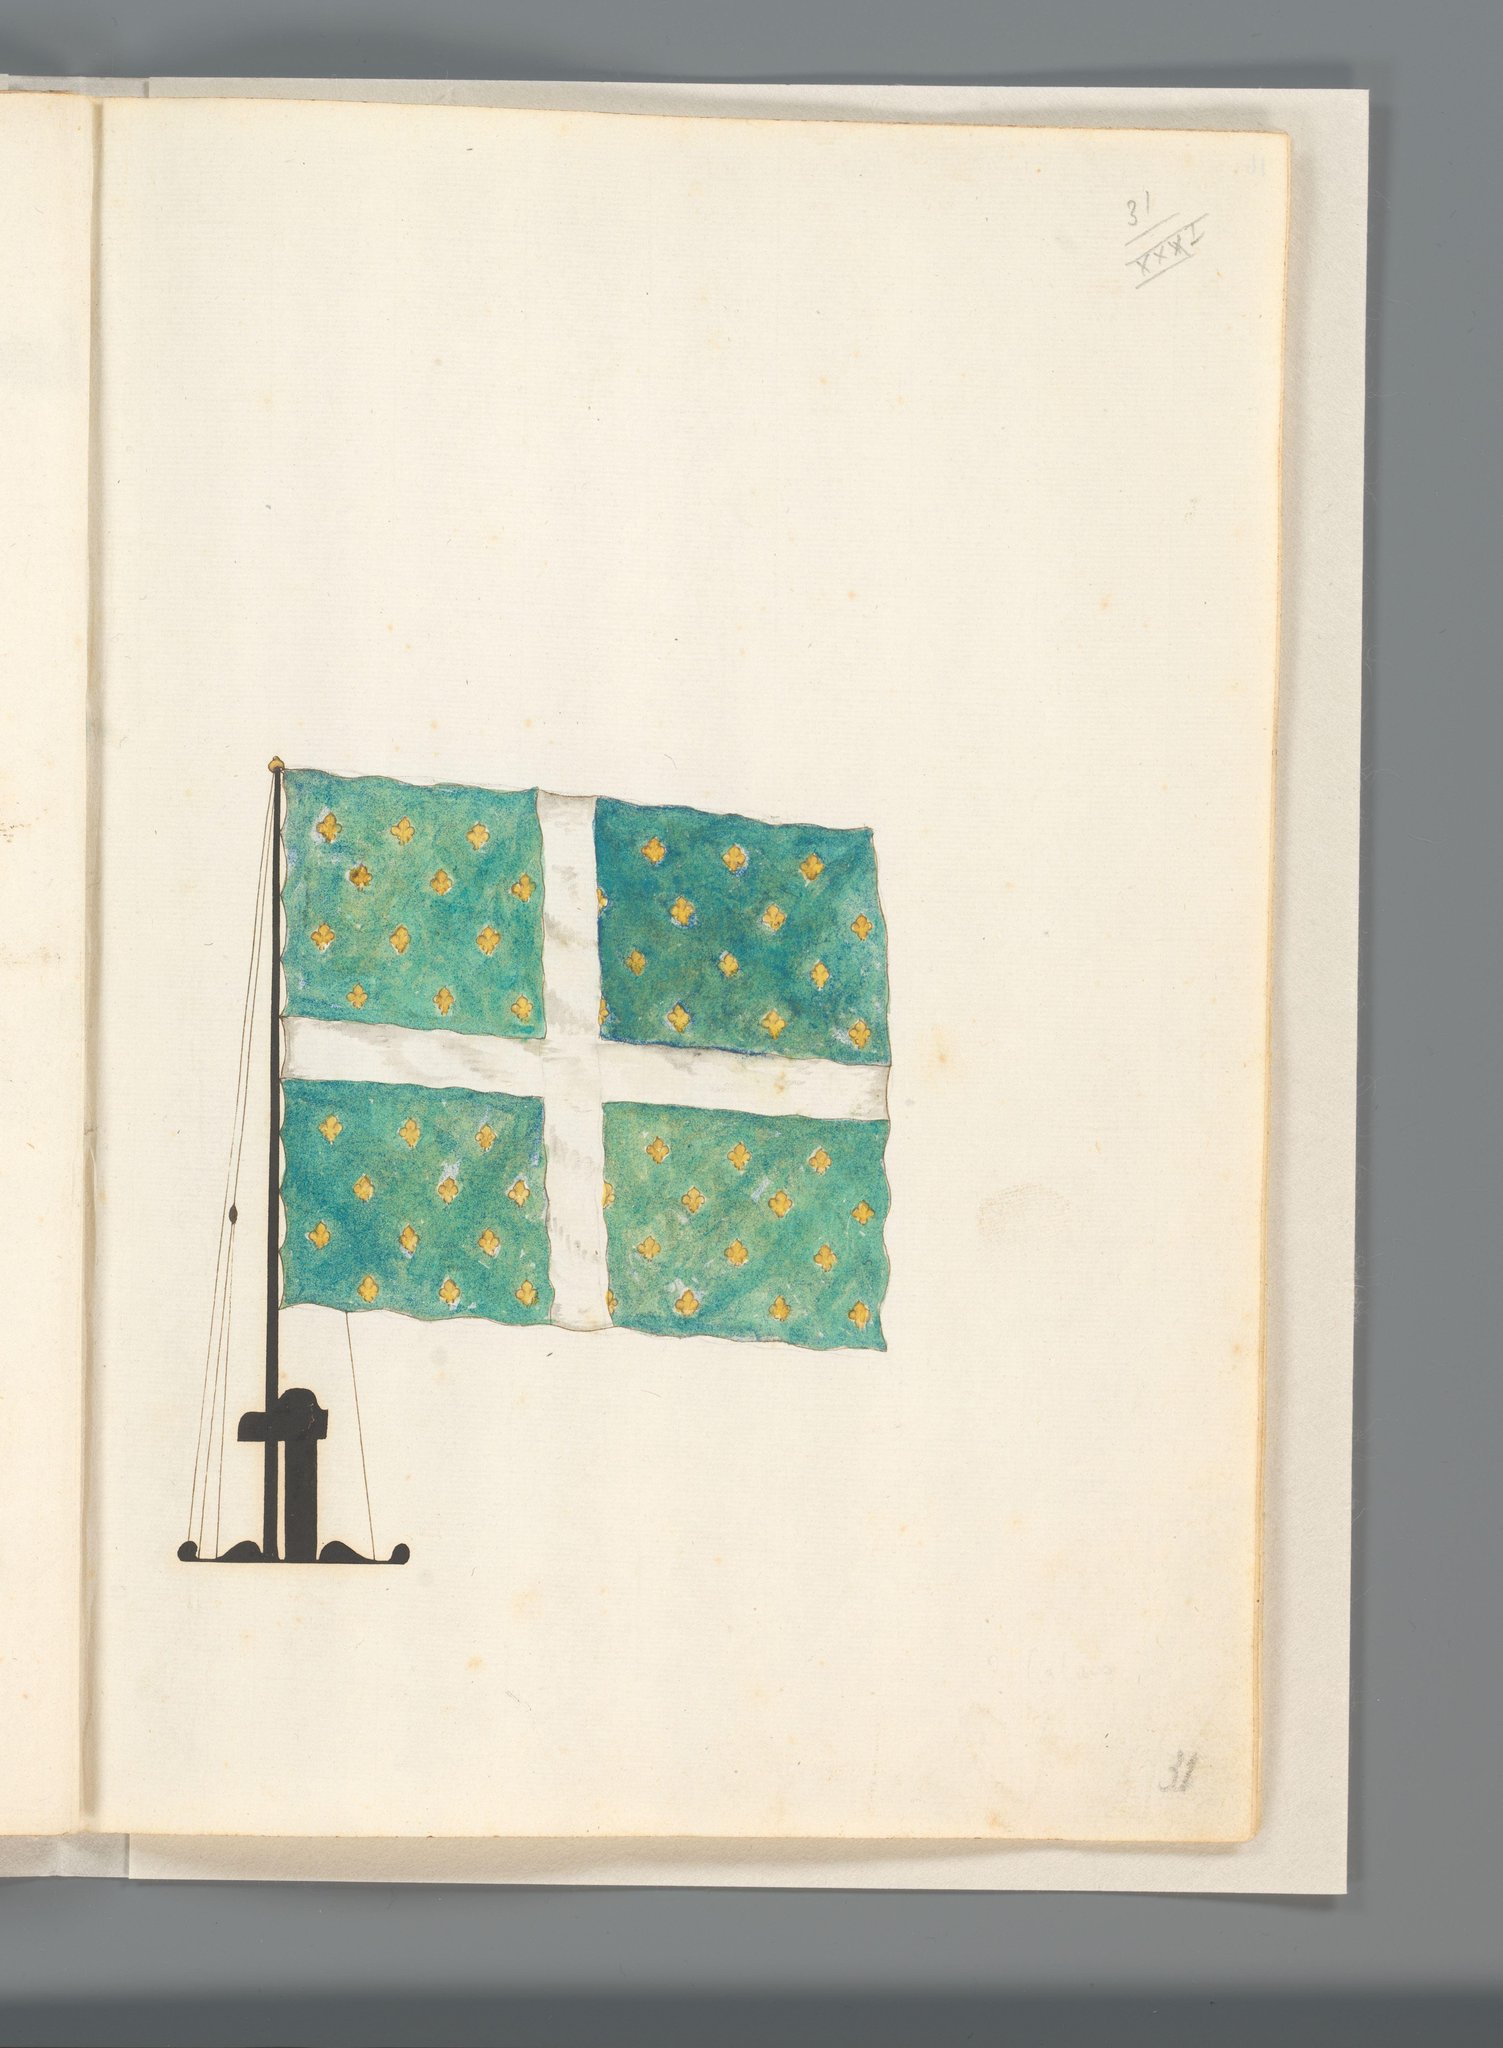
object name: drawing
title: Vlag van Frankrijk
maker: Anonymous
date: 1667-1670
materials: ink, paper, watercolor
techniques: brush, pen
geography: france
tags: flag, colours (as symbol of the state, etc.), france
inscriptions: number: ‘31 / XXXI / 31’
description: Vlag van Frankrijk, mogelijk gerelateerd aan de havenstad Calais. Blauwe vlag met staand wit kruis. Op de blauwe vlakken gele fleurs de lys. Vlag op vlaggensteng en mastvoet. Afgebeeld op folio 16r. Onderdeel van een vlaggenboek met vlaggen uit Europa, Noord-Afrika, Nabije en Verre Oosten.